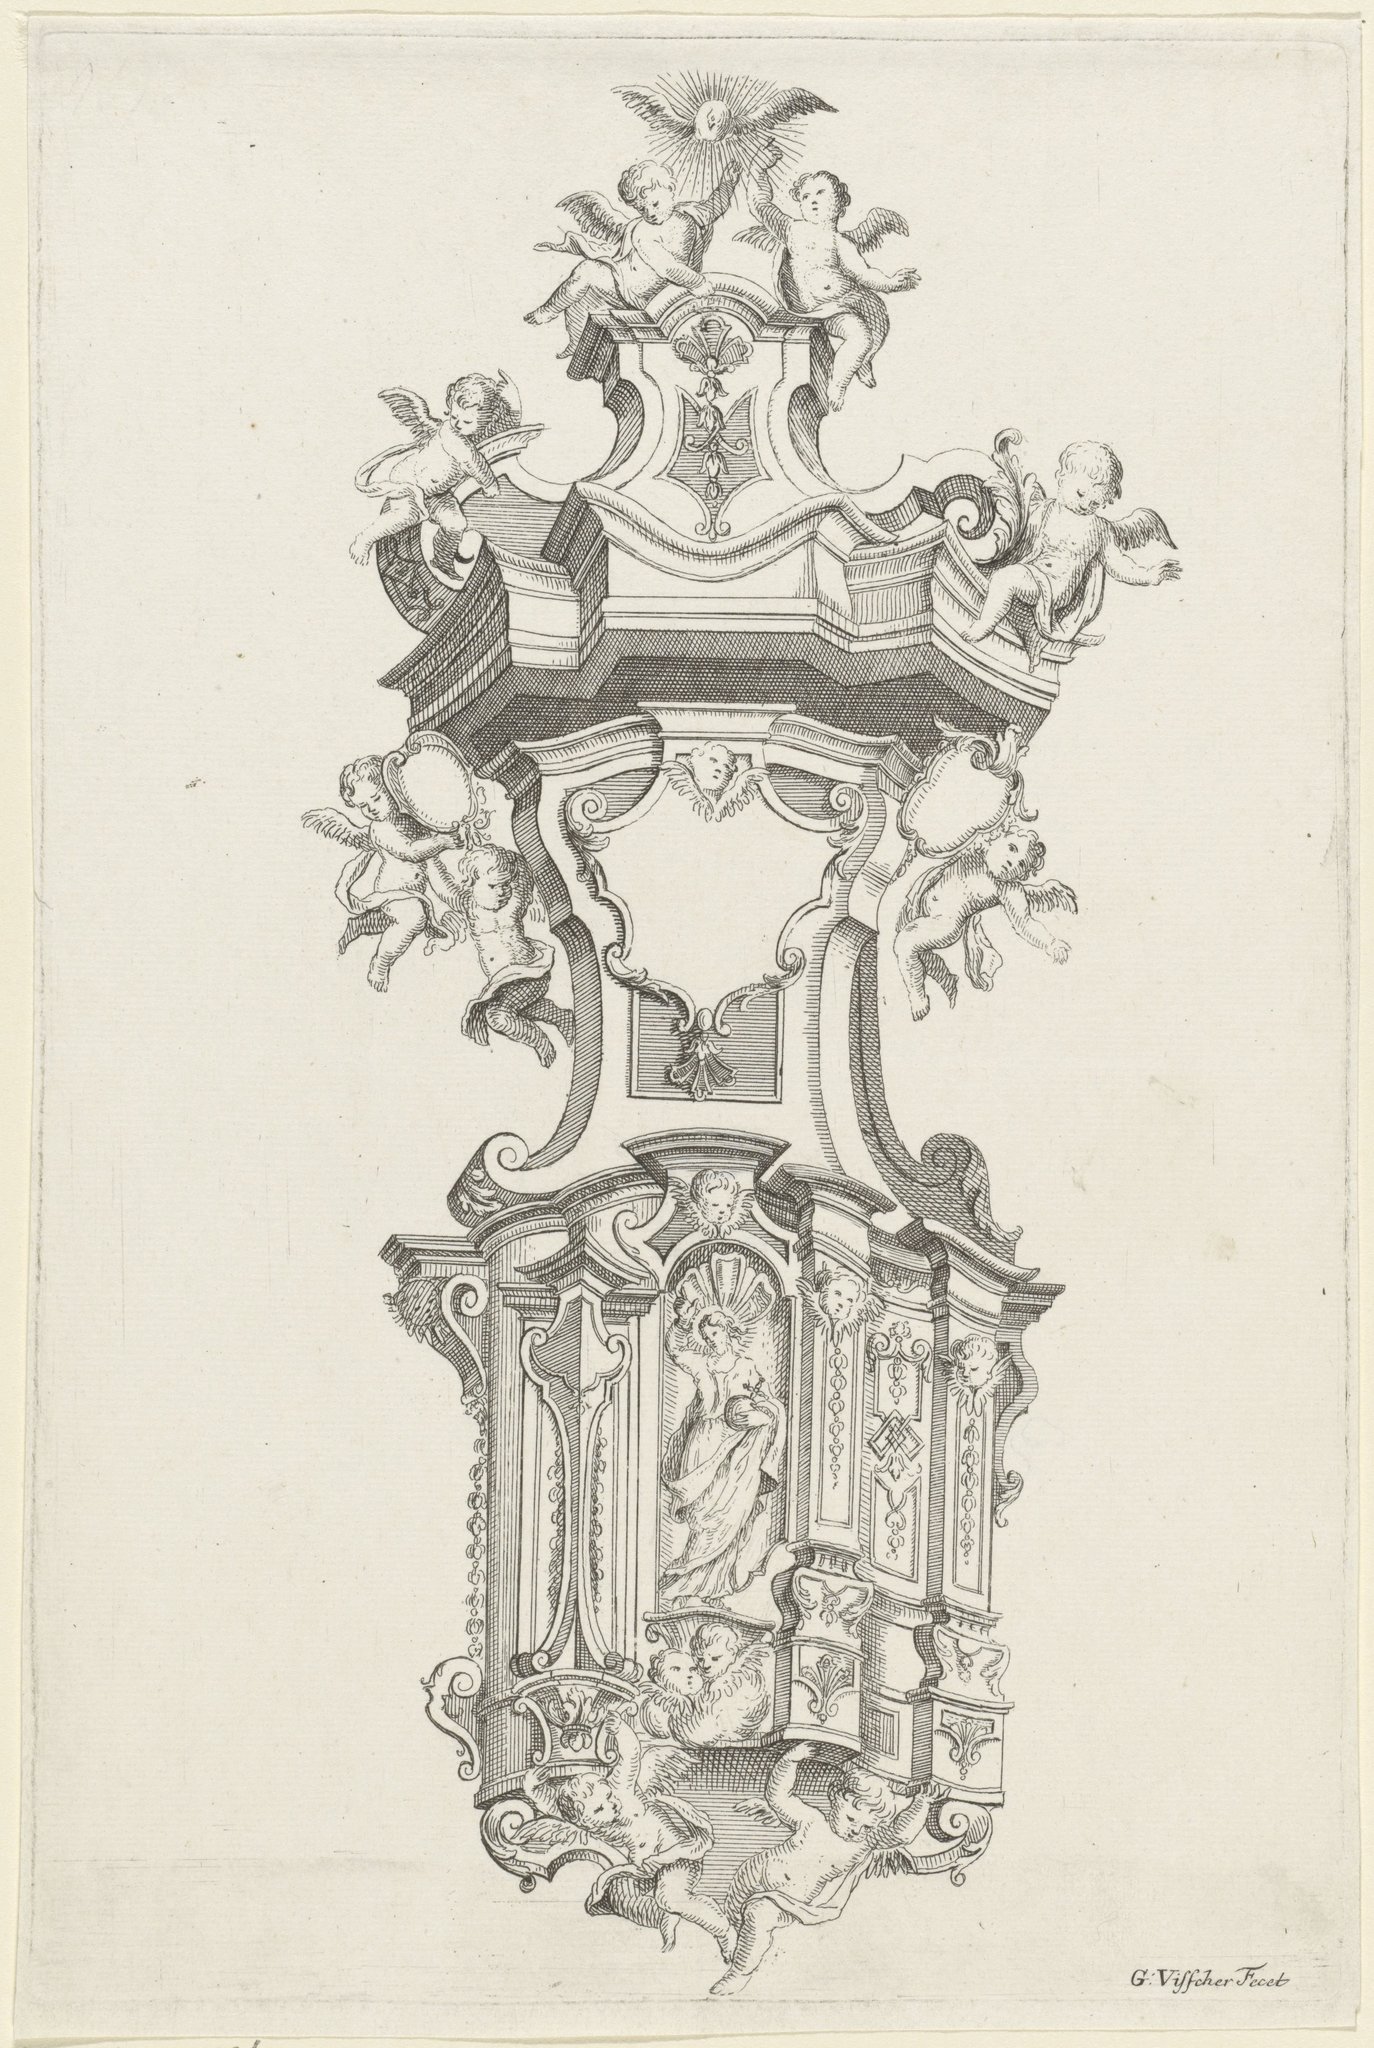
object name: print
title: Preekstoel met Christusfiguur en putti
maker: gerrit visscher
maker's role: print maker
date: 1690-1710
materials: paper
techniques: engraving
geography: amsterdam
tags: ornaments ~ art, 'salvator mundi', making a blessing gesture; an orb in his hand or at his feet, pulpit, ambo, chancel, cupids: 'amores', 'amoretti', 'putti', holy ghost represented as a dove (in flames)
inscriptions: collector's mark: Lugt 2228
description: Een ornamentele preekstoel versierd met putti en cherubijnen en in het midden op de buitenzijde van het spreekgestoelte Christus als Salvator Mundi. Geheel bovenaan de duif van de Heilige Geest.